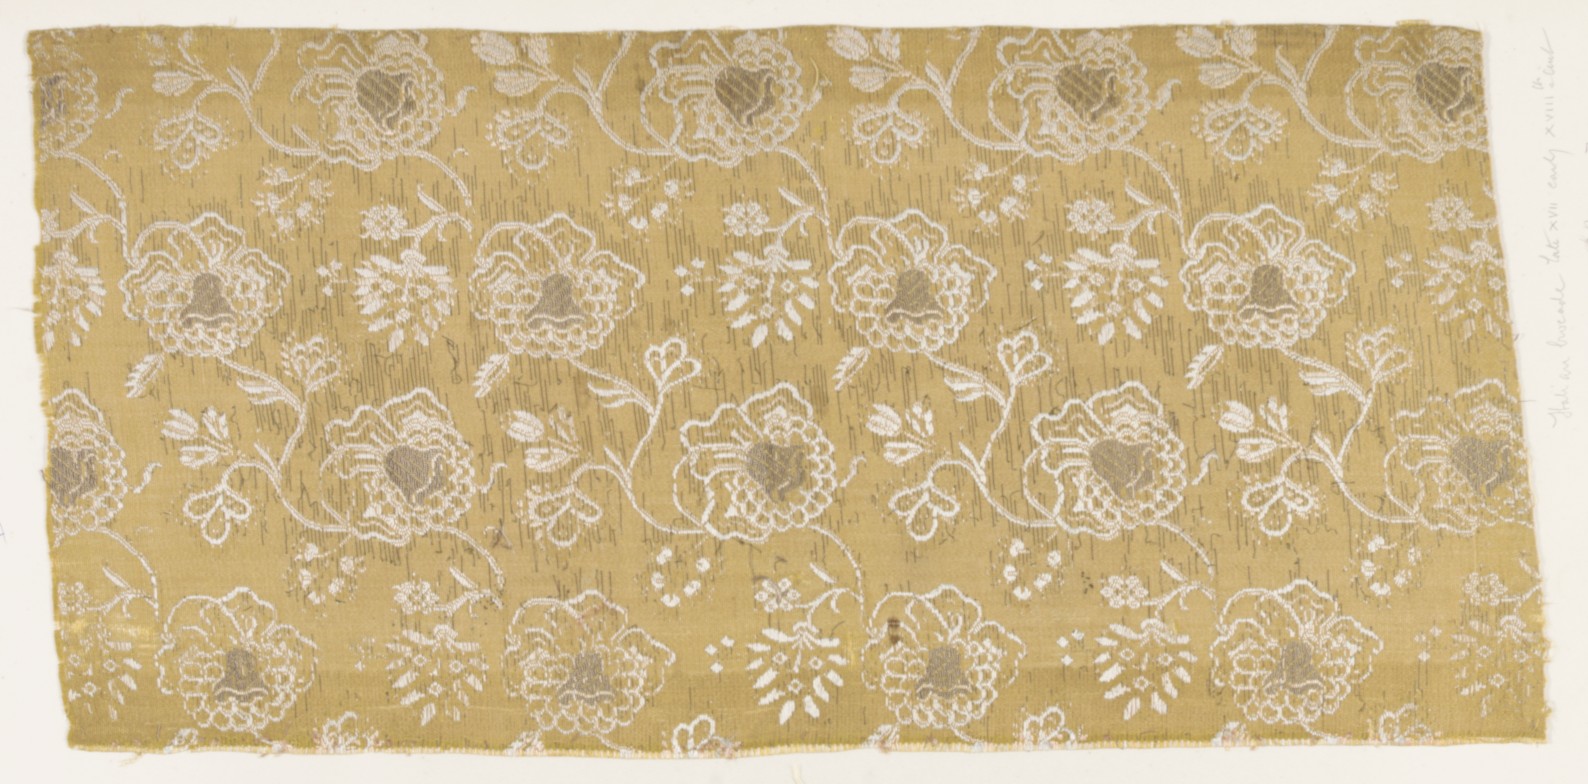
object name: fragment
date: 1667-1733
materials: metal thread, silk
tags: flowers